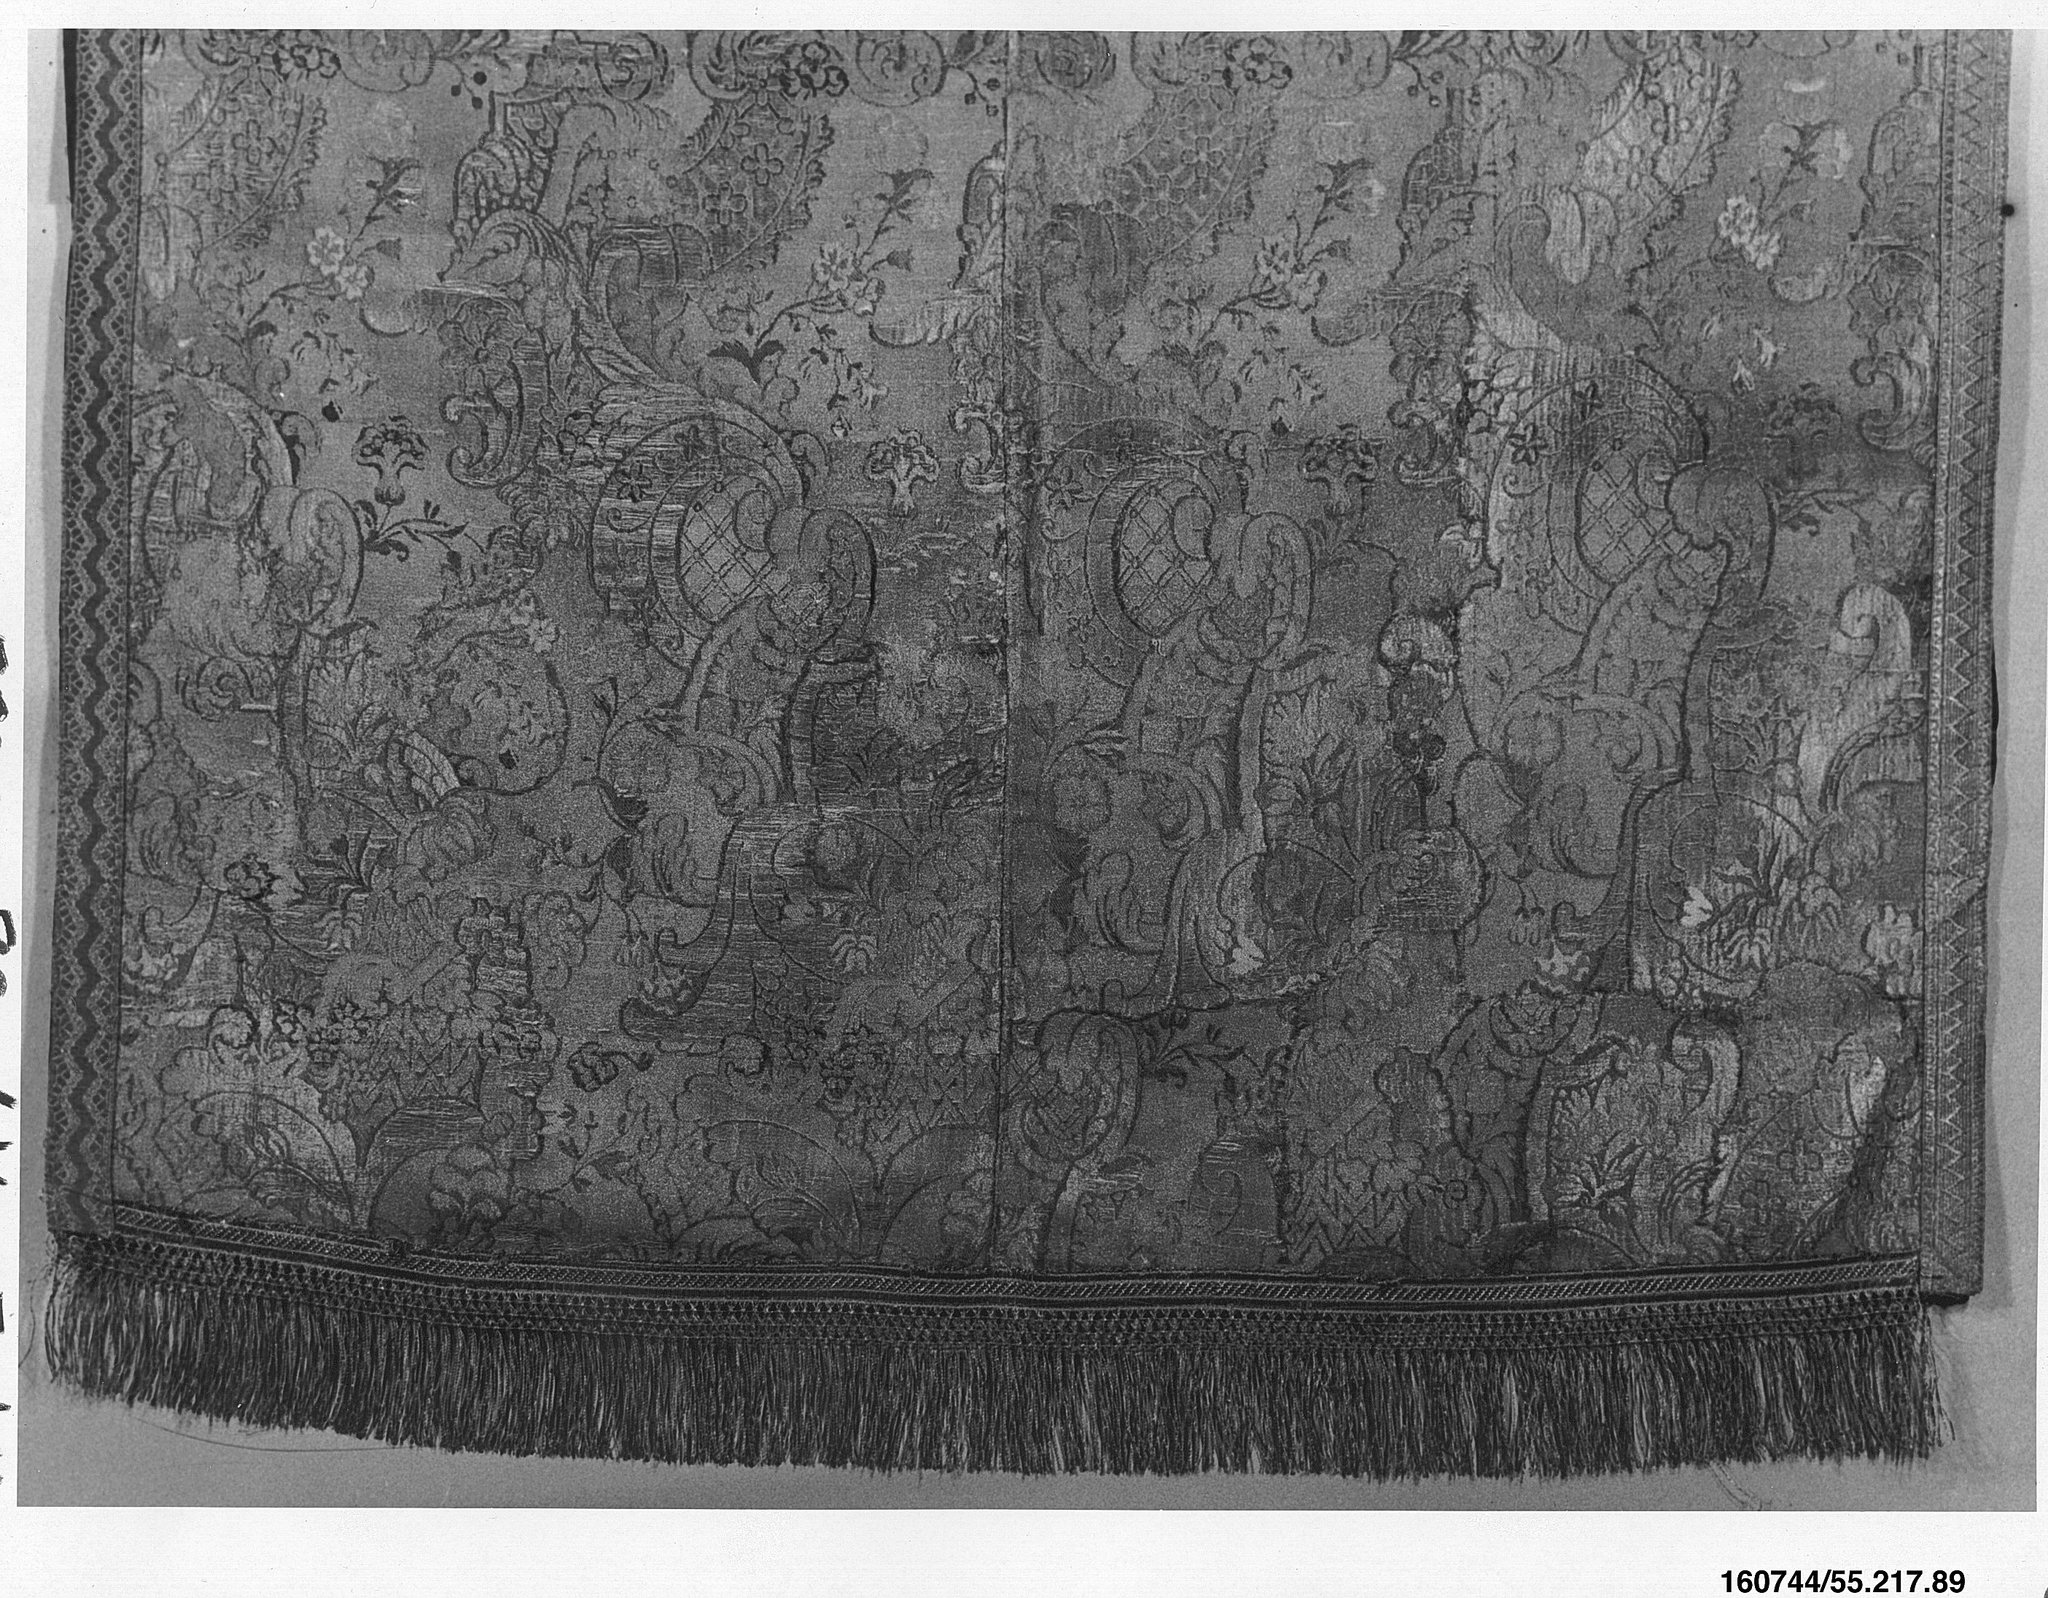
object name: piece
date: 1720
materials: metal thread, silk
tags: flowers